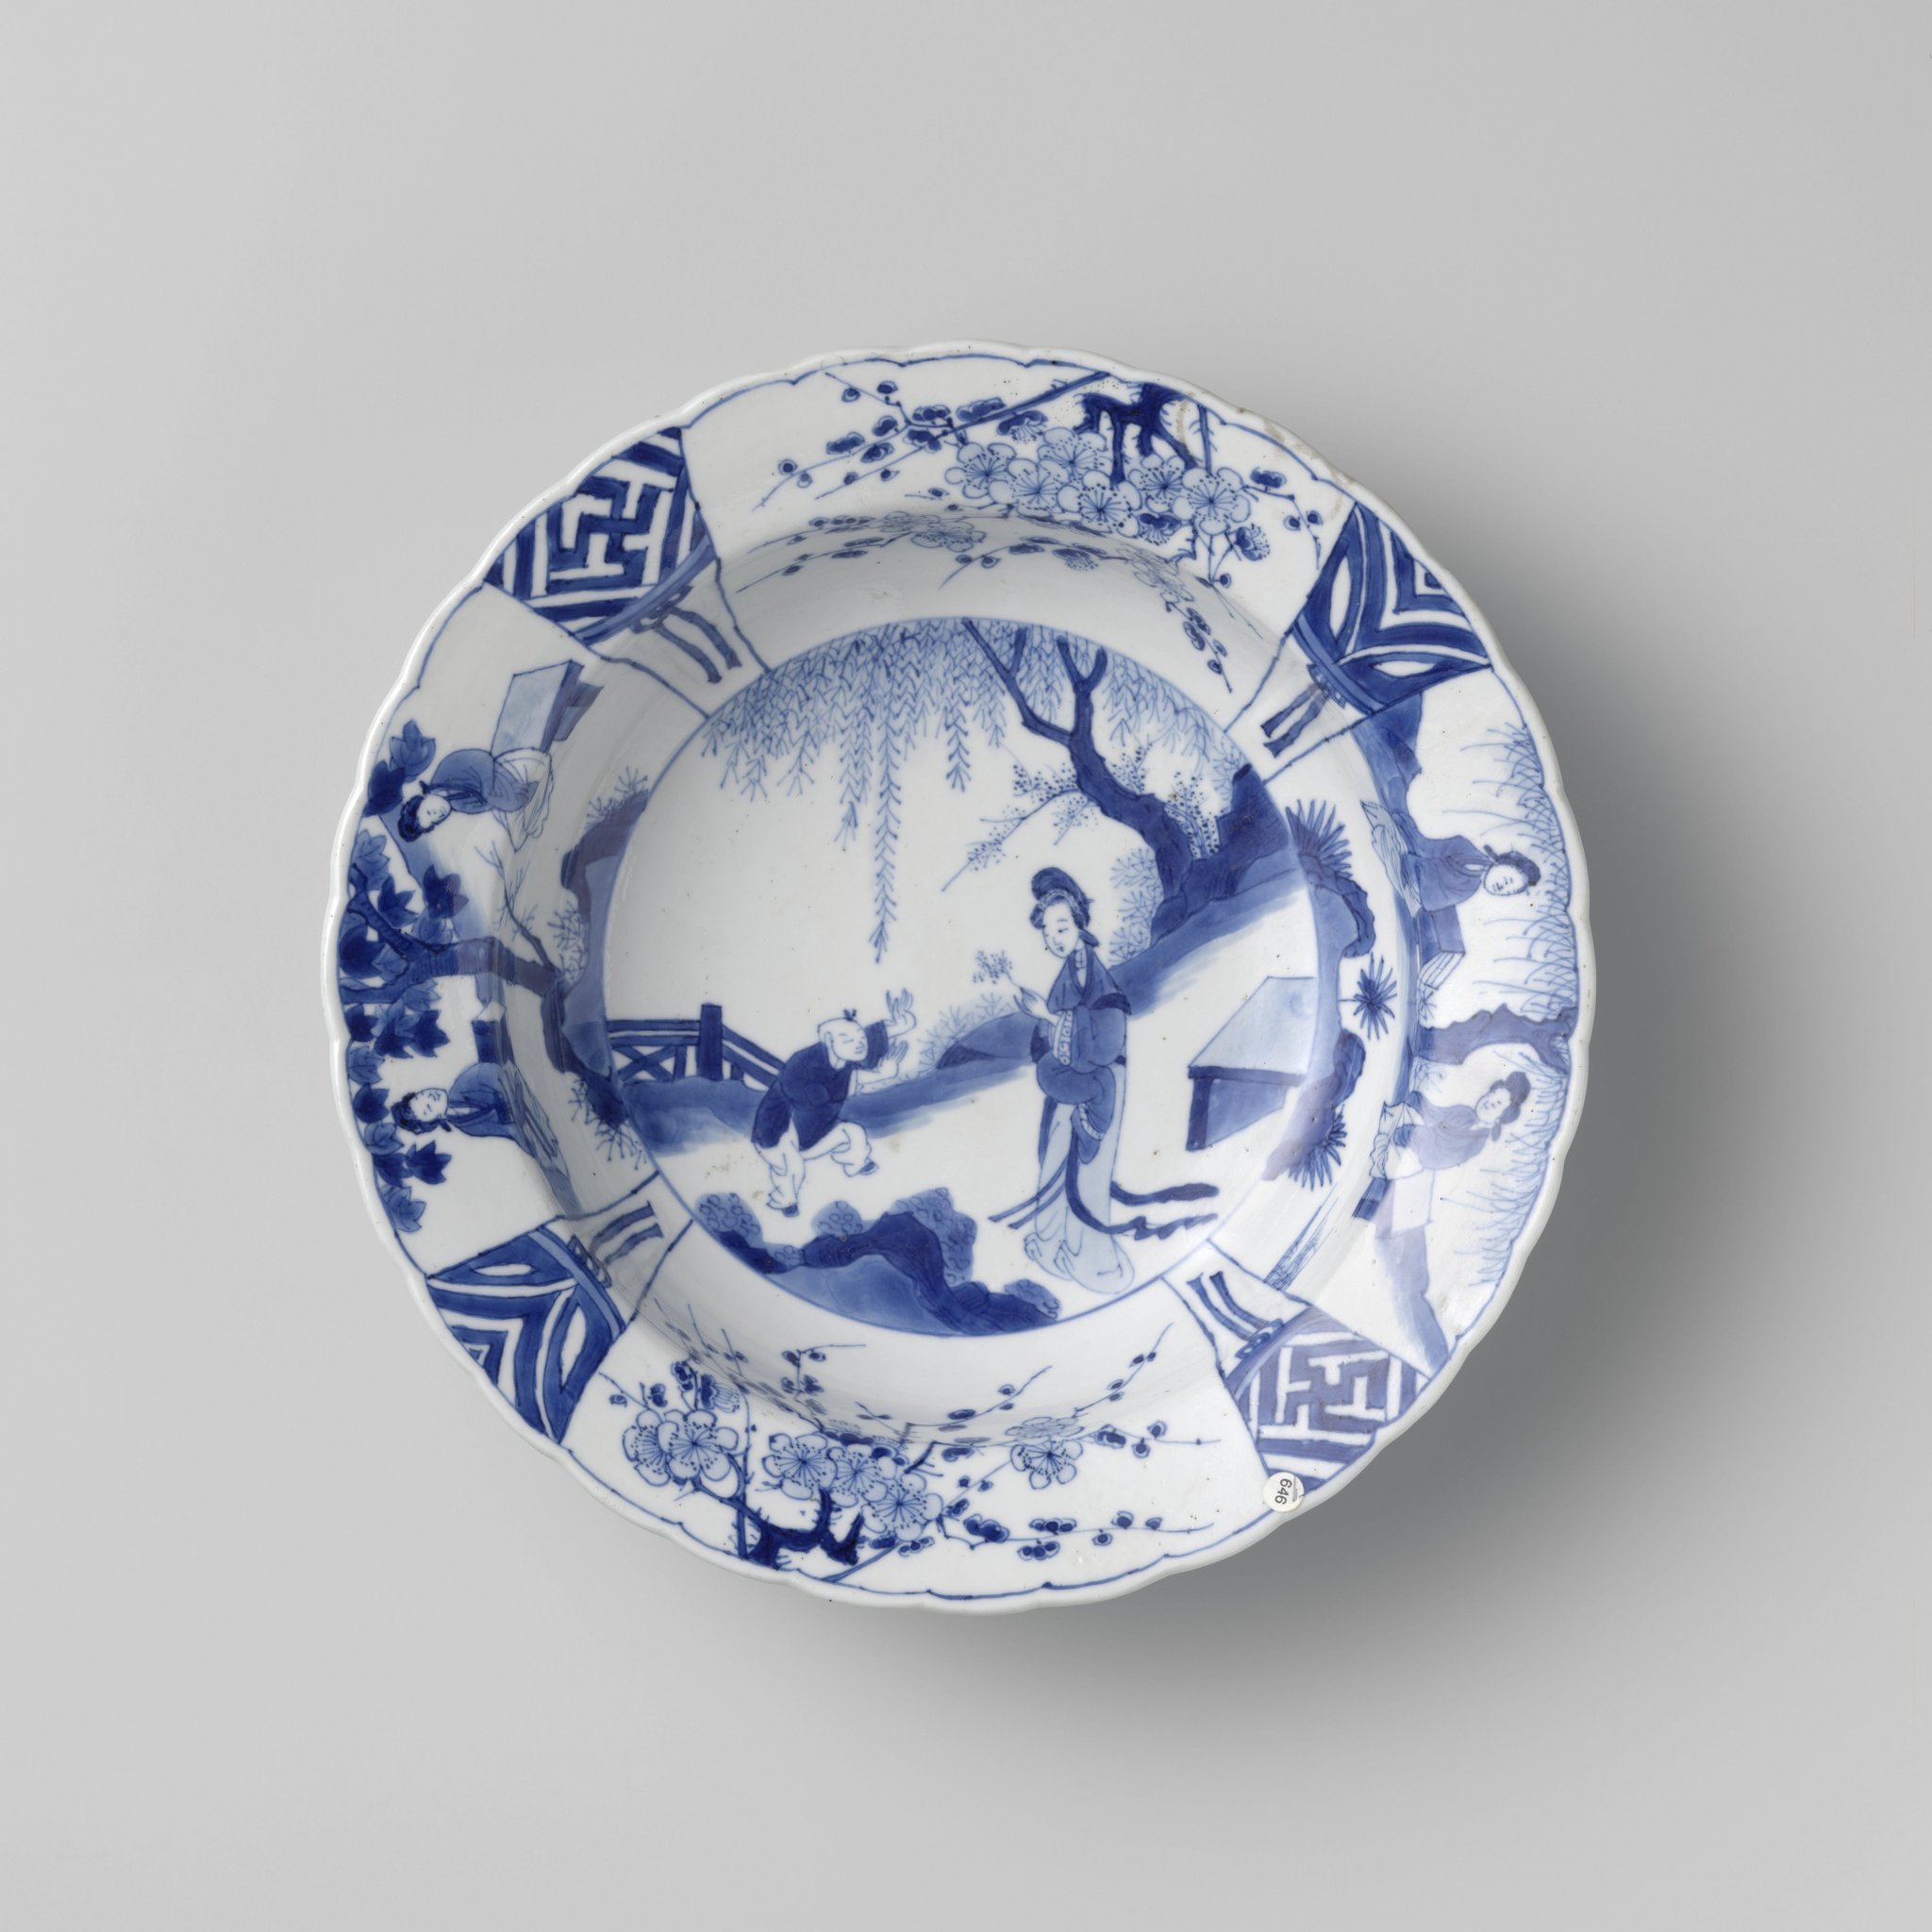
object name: dish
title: Deep dish with flower sprays, women and boys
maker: Anonymous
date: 1680-1720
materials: cobalt, glaze, paint, porcelain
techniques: firing, turning, vitrification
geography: china